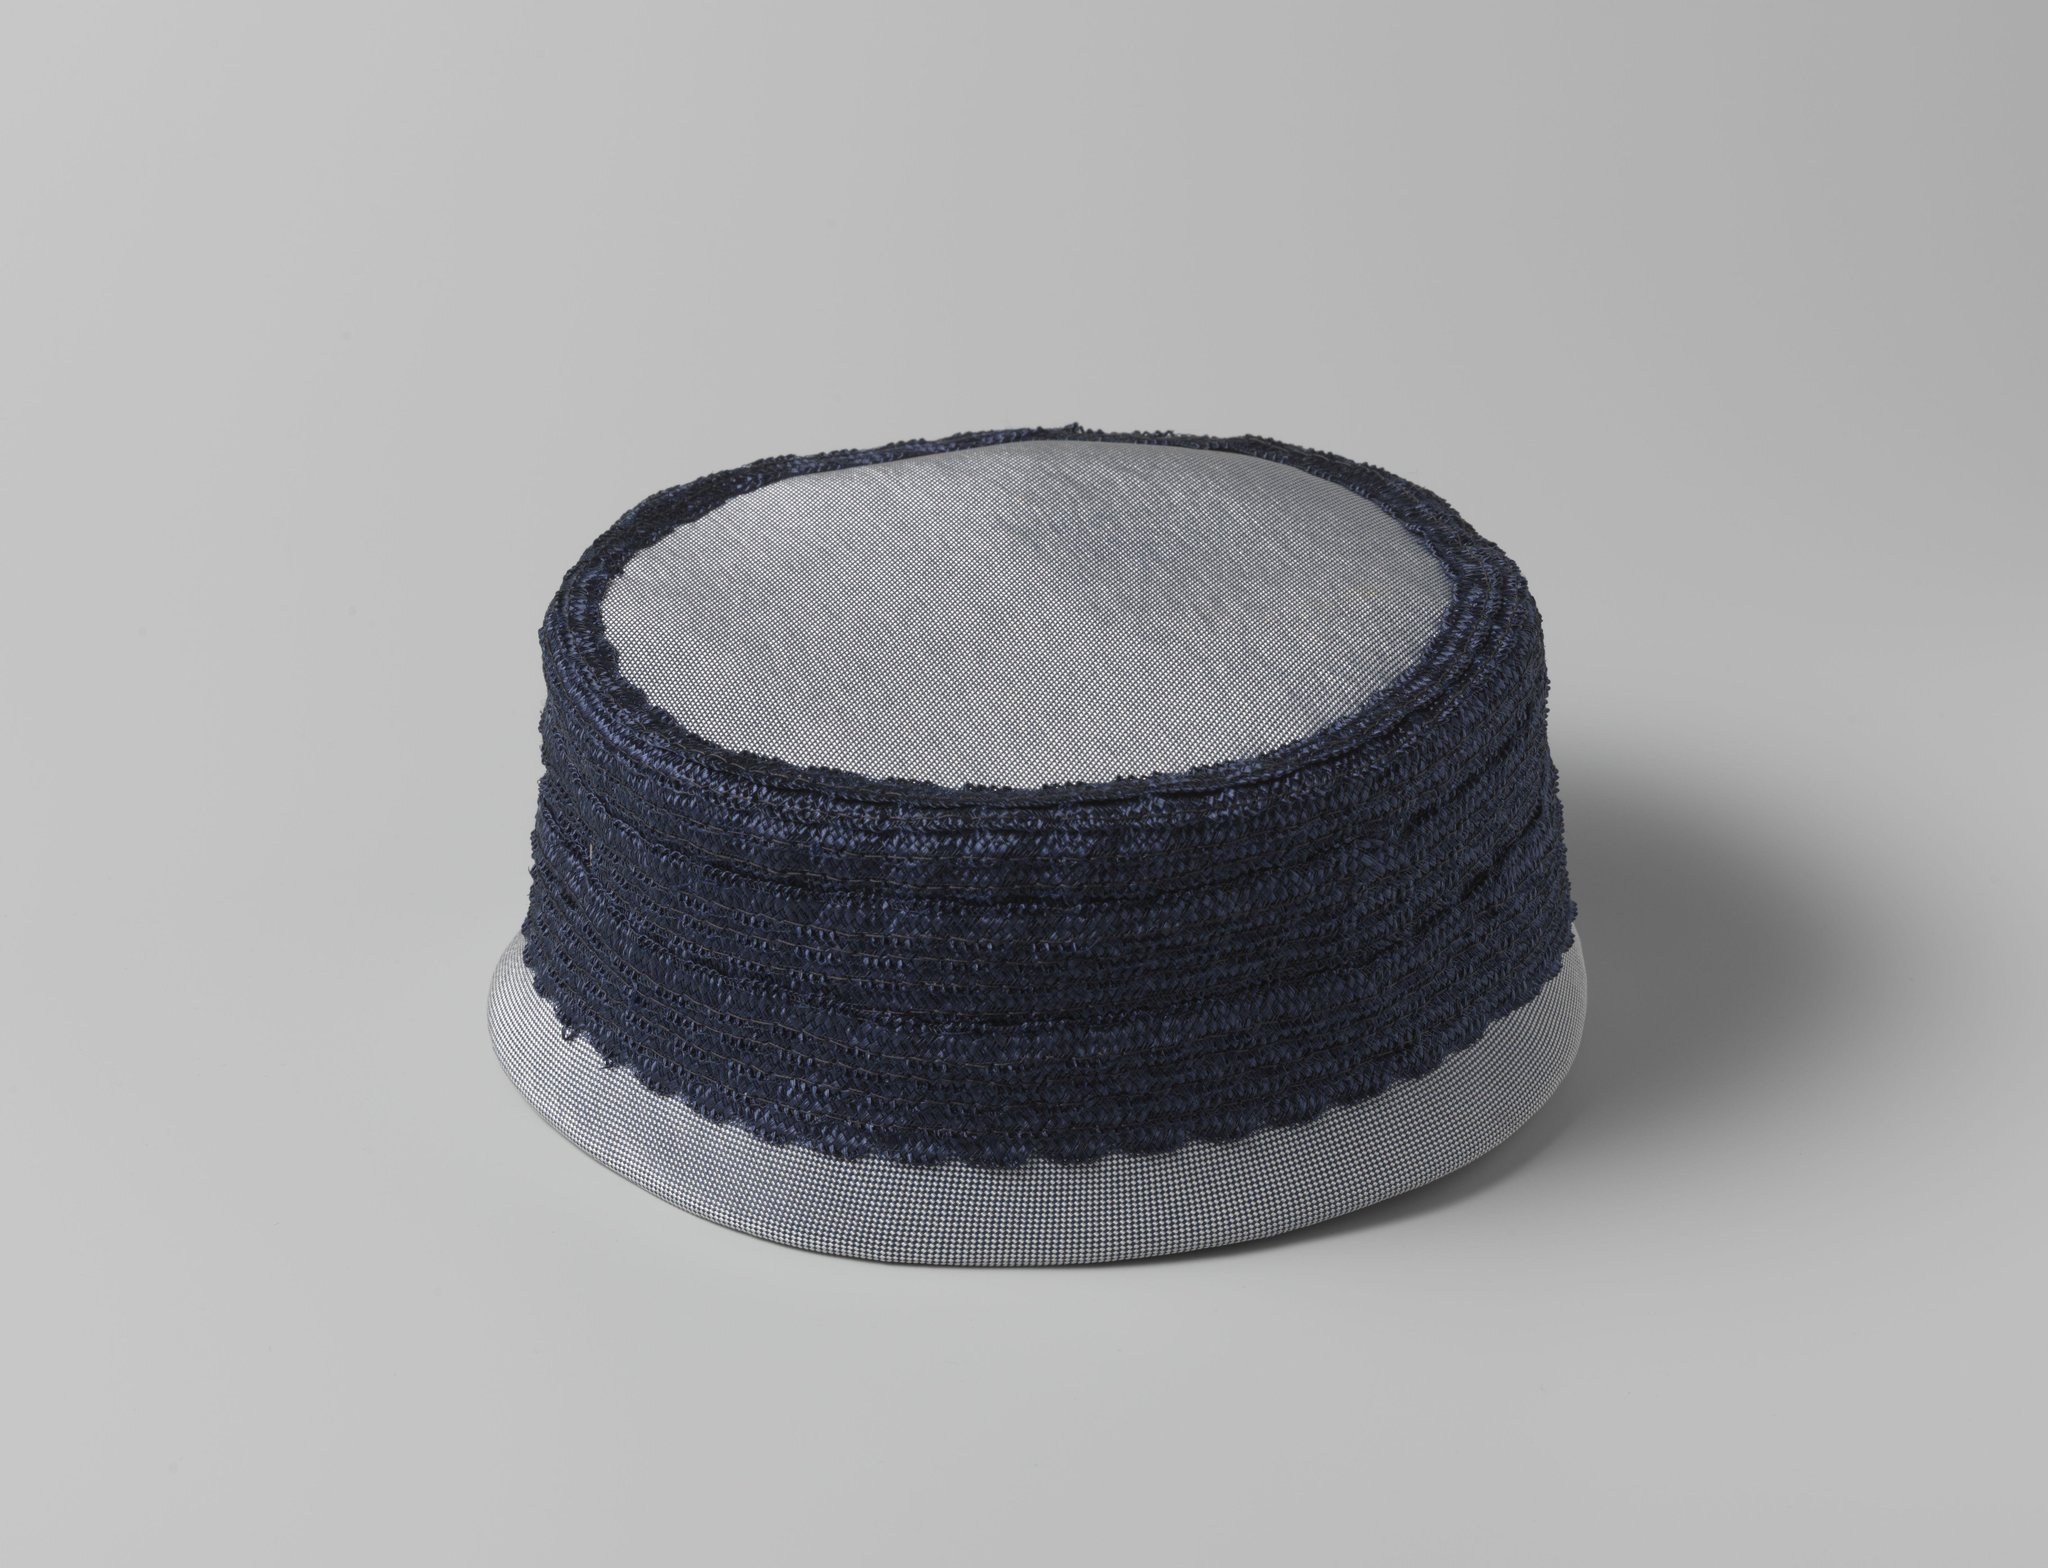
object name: zomerhoed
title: Zomerhoed van fijn geruite blauwgrijze zijde en donkerblauw stro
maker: Anonymous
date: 1955-1956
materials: silk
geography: netherlands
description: Zomerhoed van fijn geruite blauwgrijze zijde en donkerblauw stro. Bijna cylindrische toque van met stof overtrokken strooien vorm met platte bodem en iets uitstaand ondereind. Rondom loopt een brede blauwe strooien band over de gehele hoogte, zelfs iets over de platte bodem heen, maar onderaan een eindje van de kant af. Voering en adres zijn verdwenen.